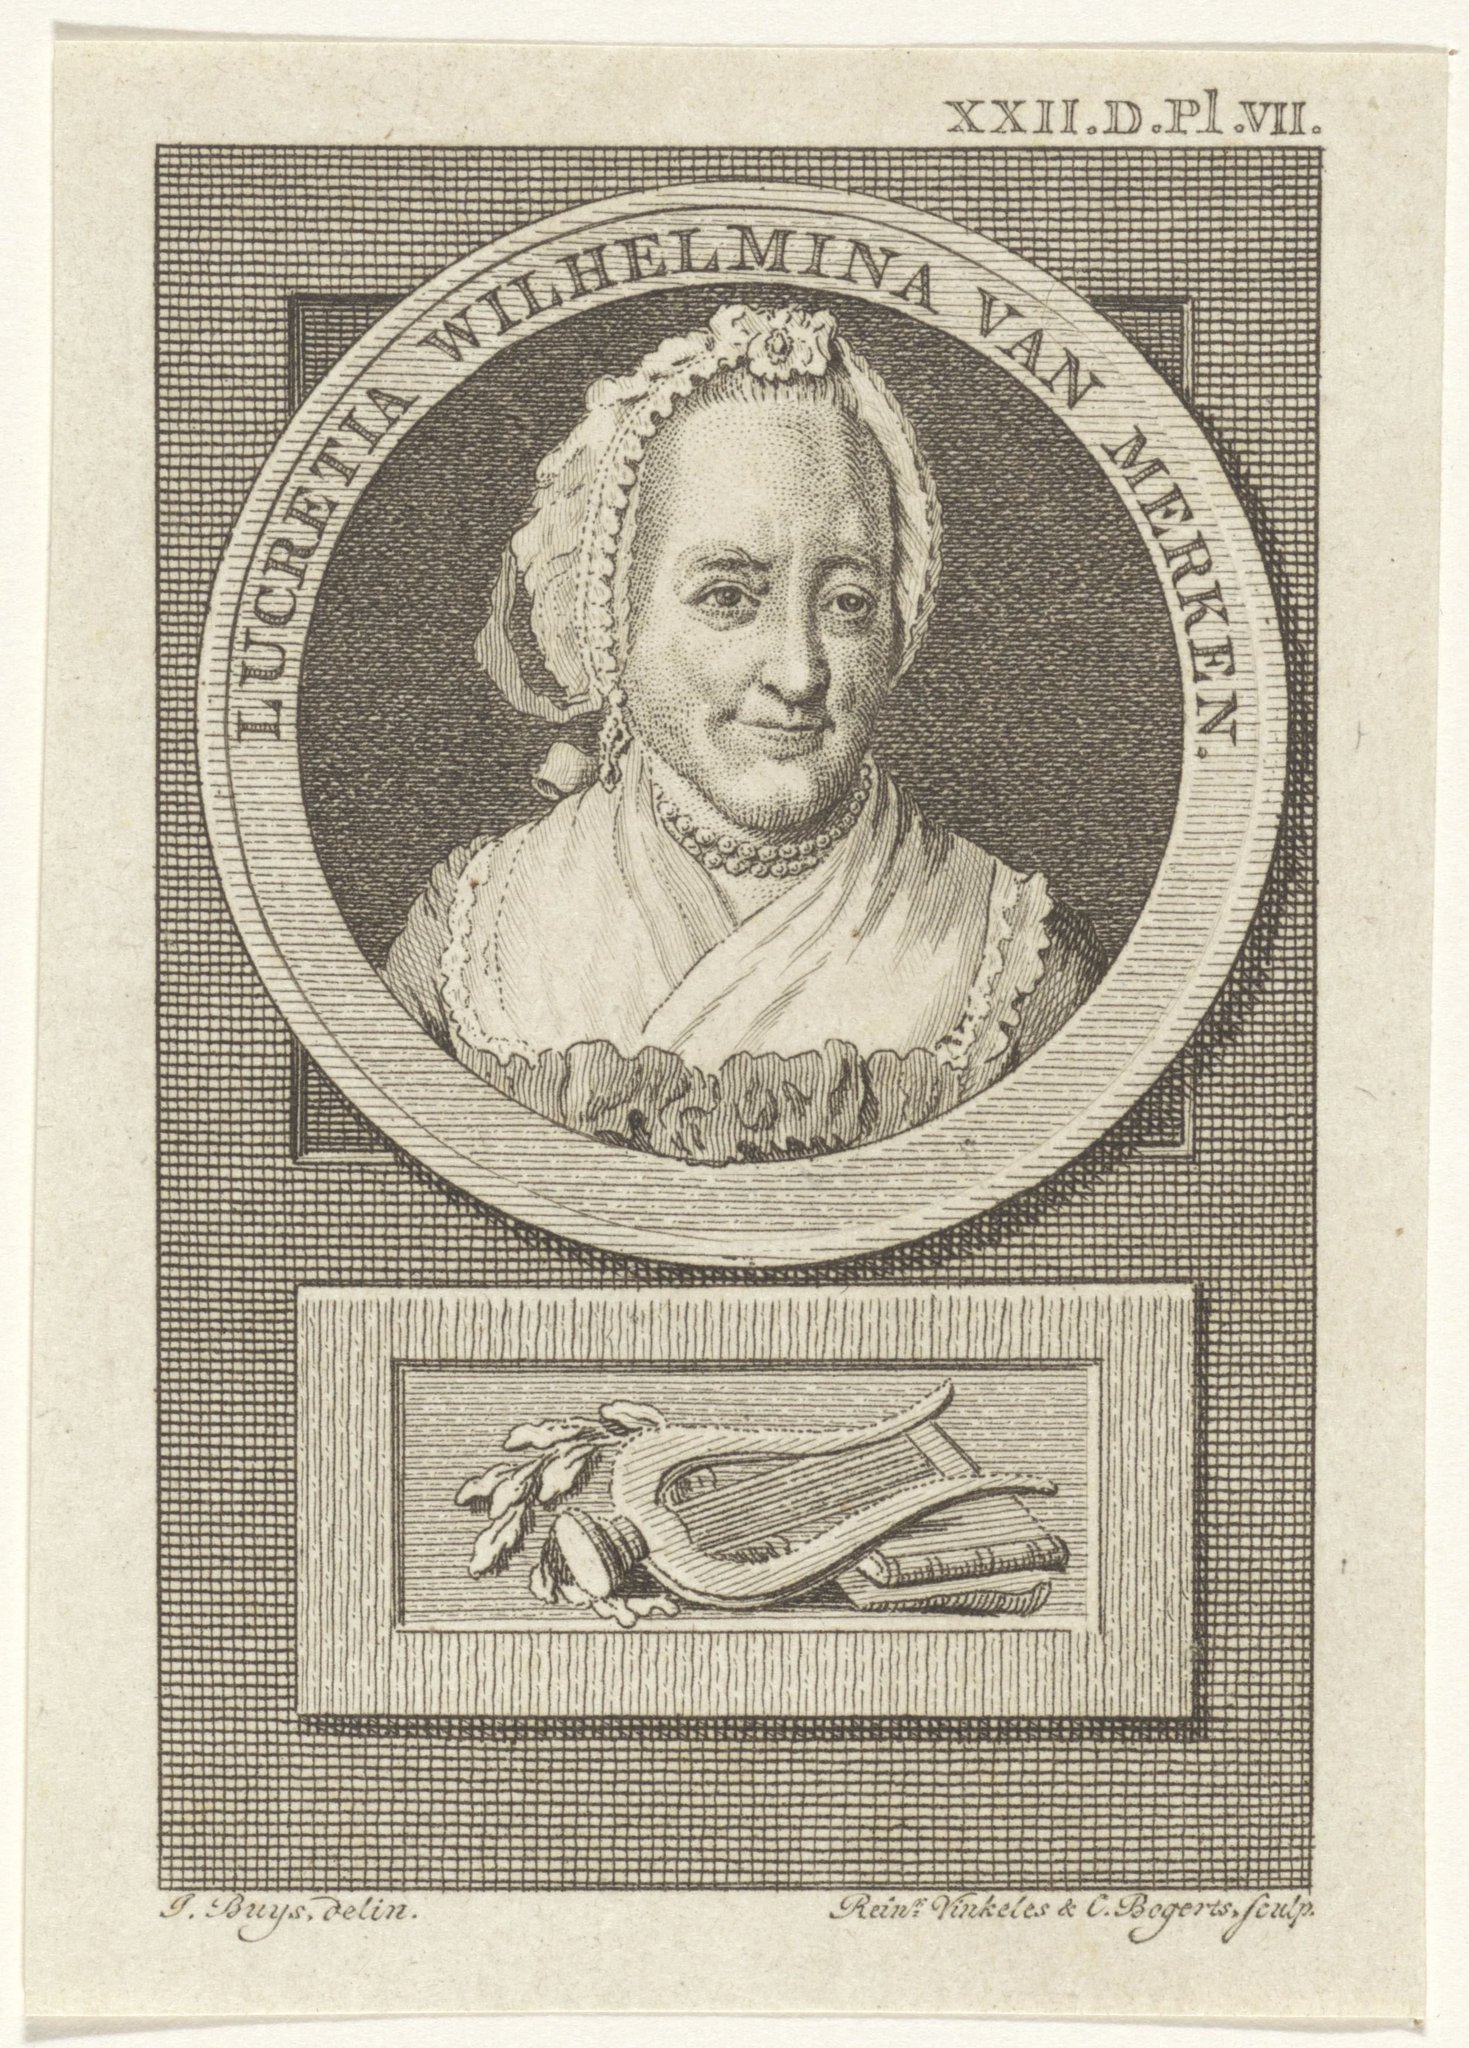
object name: print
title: Portret van Lucretia Wilhelmina van Merken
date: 1783-1795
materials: paper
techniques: engraving, etching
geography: amsterdam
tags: leiden, lucretia wilhelmina van merken, honouring the artist with laurel wreath (+ variant), lyre, cithara, psaltery, book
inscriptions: collector's mark: Lugt 2228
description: Prent gebruikt in: Fokke, Jan. Geschiedenissen der Vereenigde Nederlanden voor de vaderlandsche jeugd Ie-XXVste deel. Amsterdam: Johannes Allart, 1783-1795. Deel XXII.